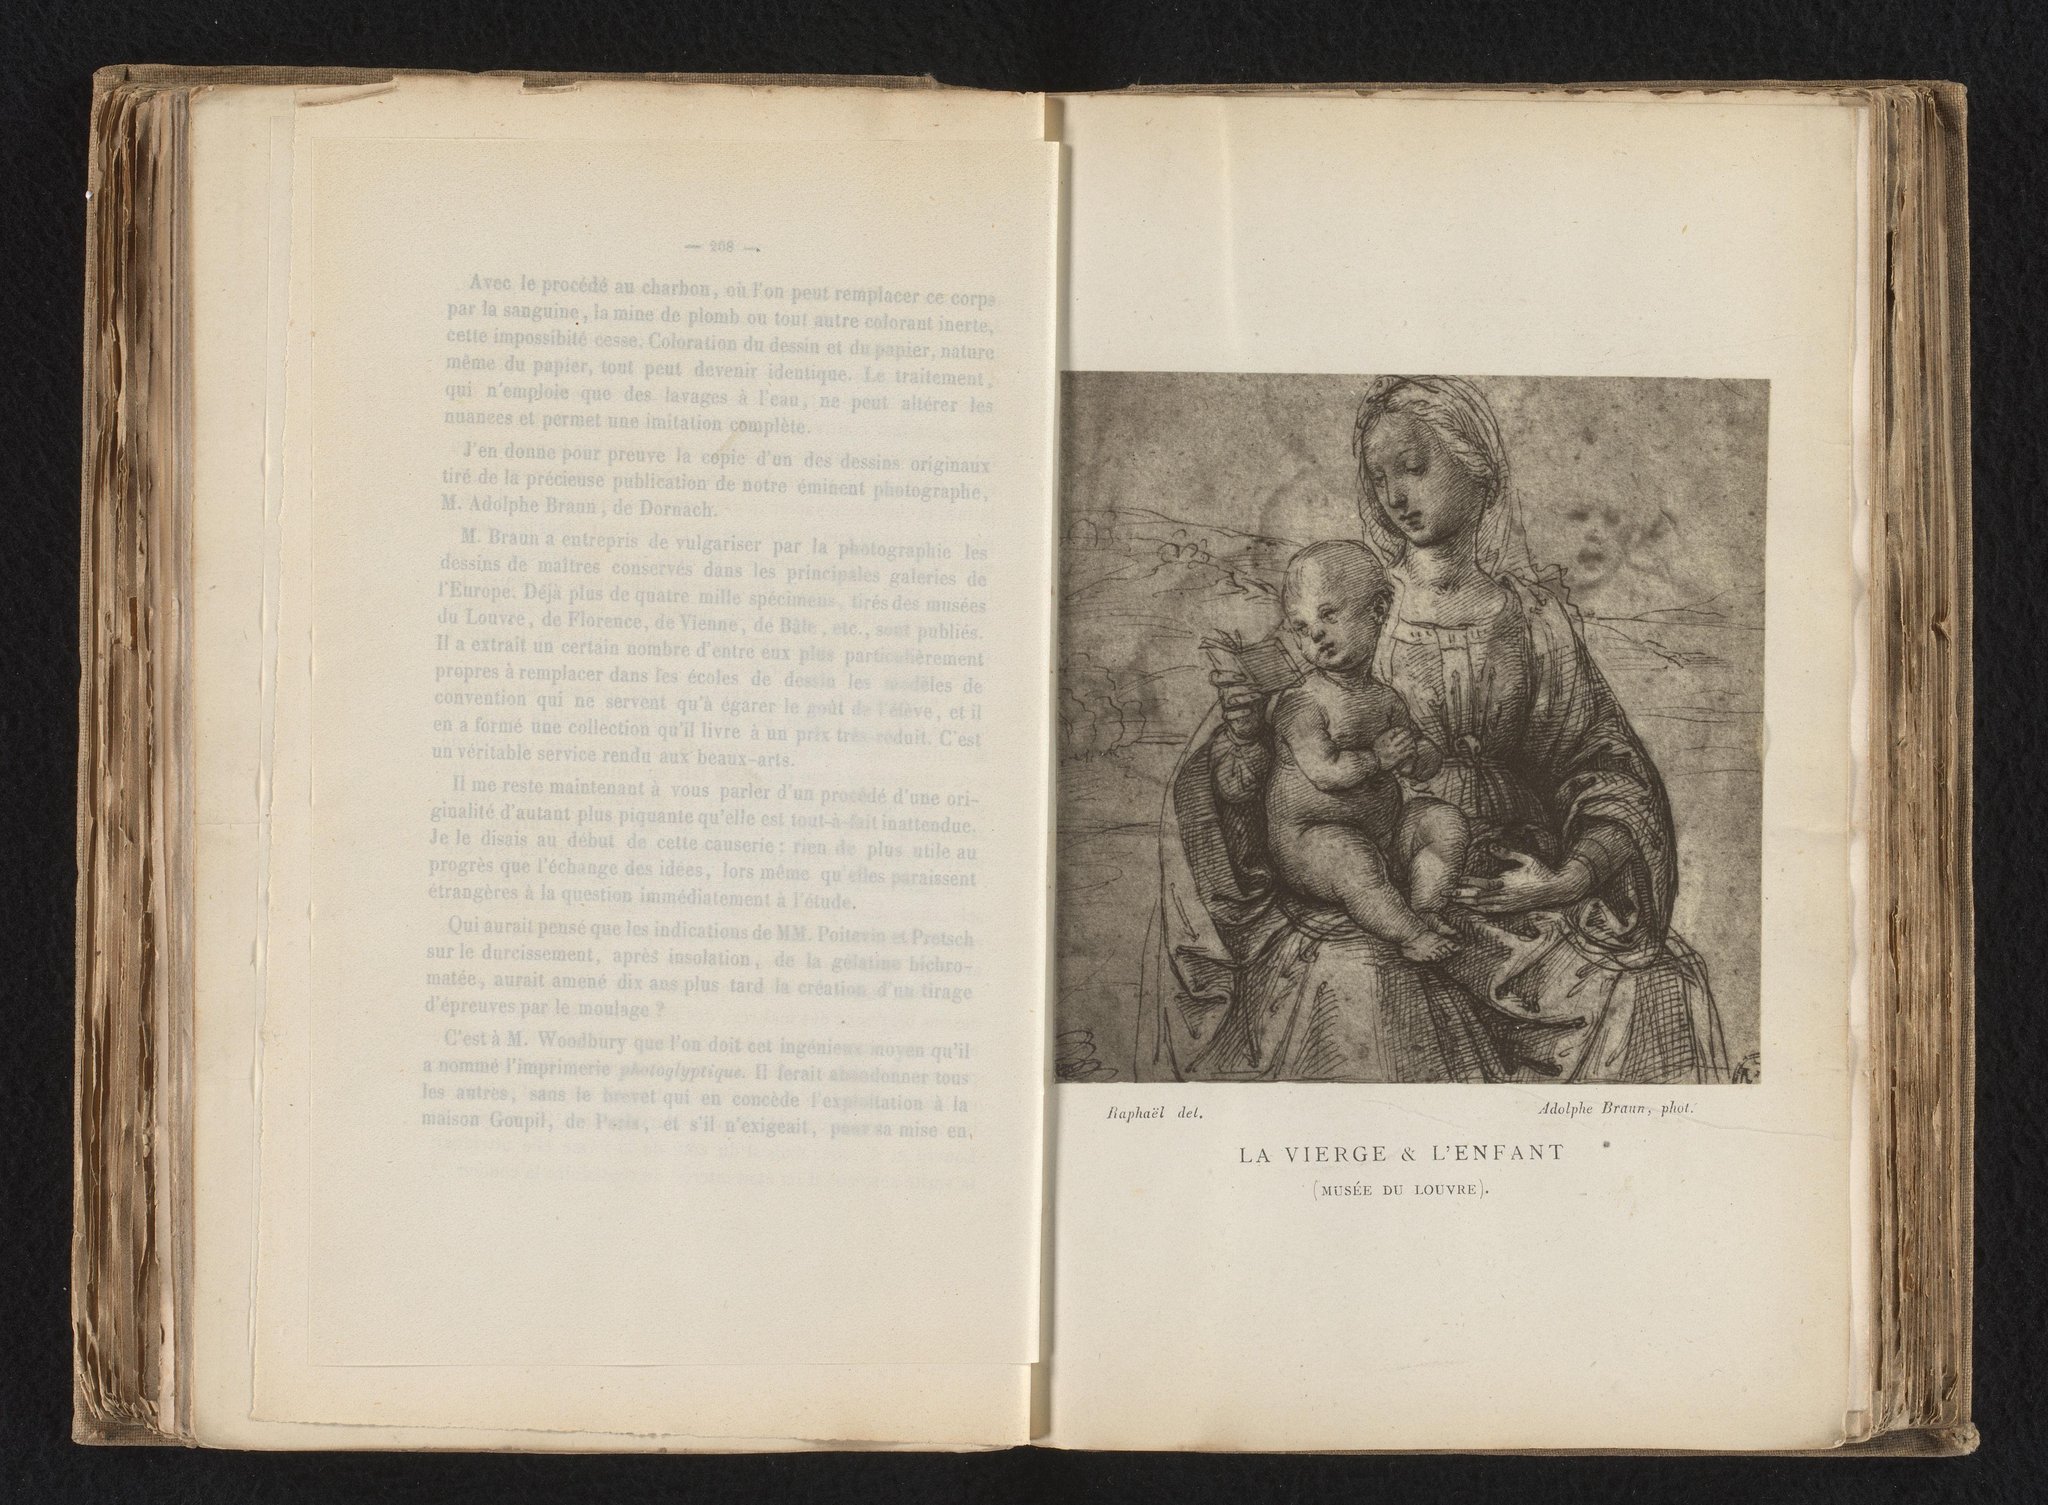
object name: page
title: Fotoreproductie van de tekening La vierge et l'enfant door Rafaël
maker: rafaël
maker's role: painter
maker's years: 1483-1520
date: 1865-1870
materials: paper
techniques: albumen print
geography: paris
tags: drawing, madonna: i.e. mary with the christ-child